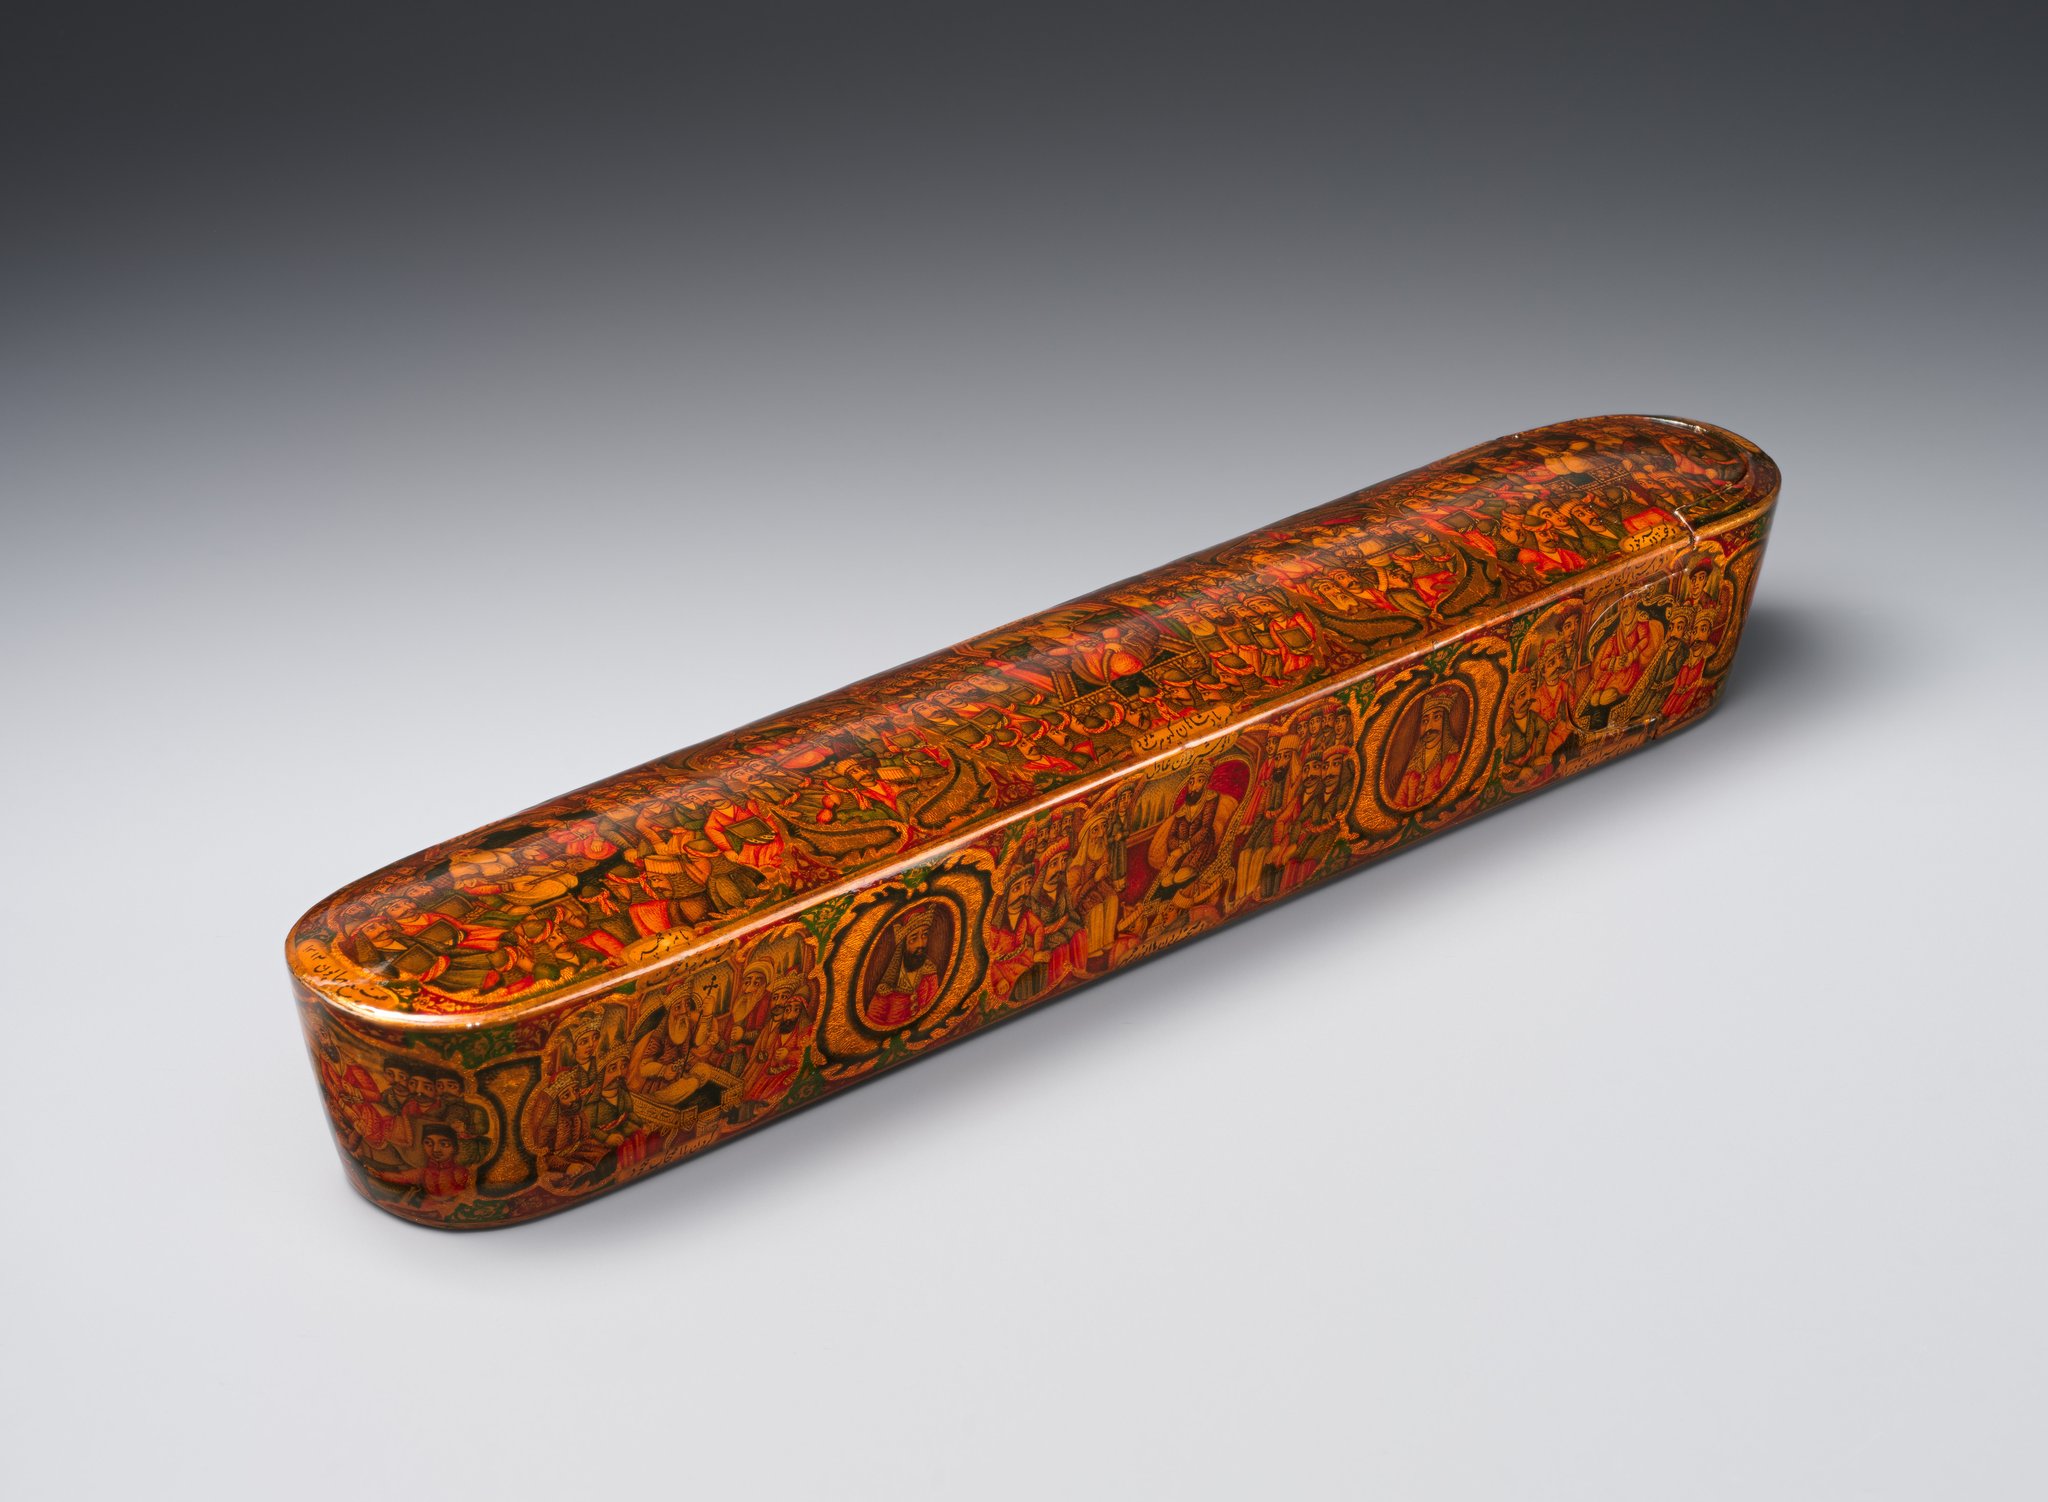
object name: pen box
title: Lacquer Pen Box with Royal Audience Scenes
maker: sani' humayun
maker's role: artist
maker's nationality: iranian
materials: paper, varnish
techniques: gilding, painting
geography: iran